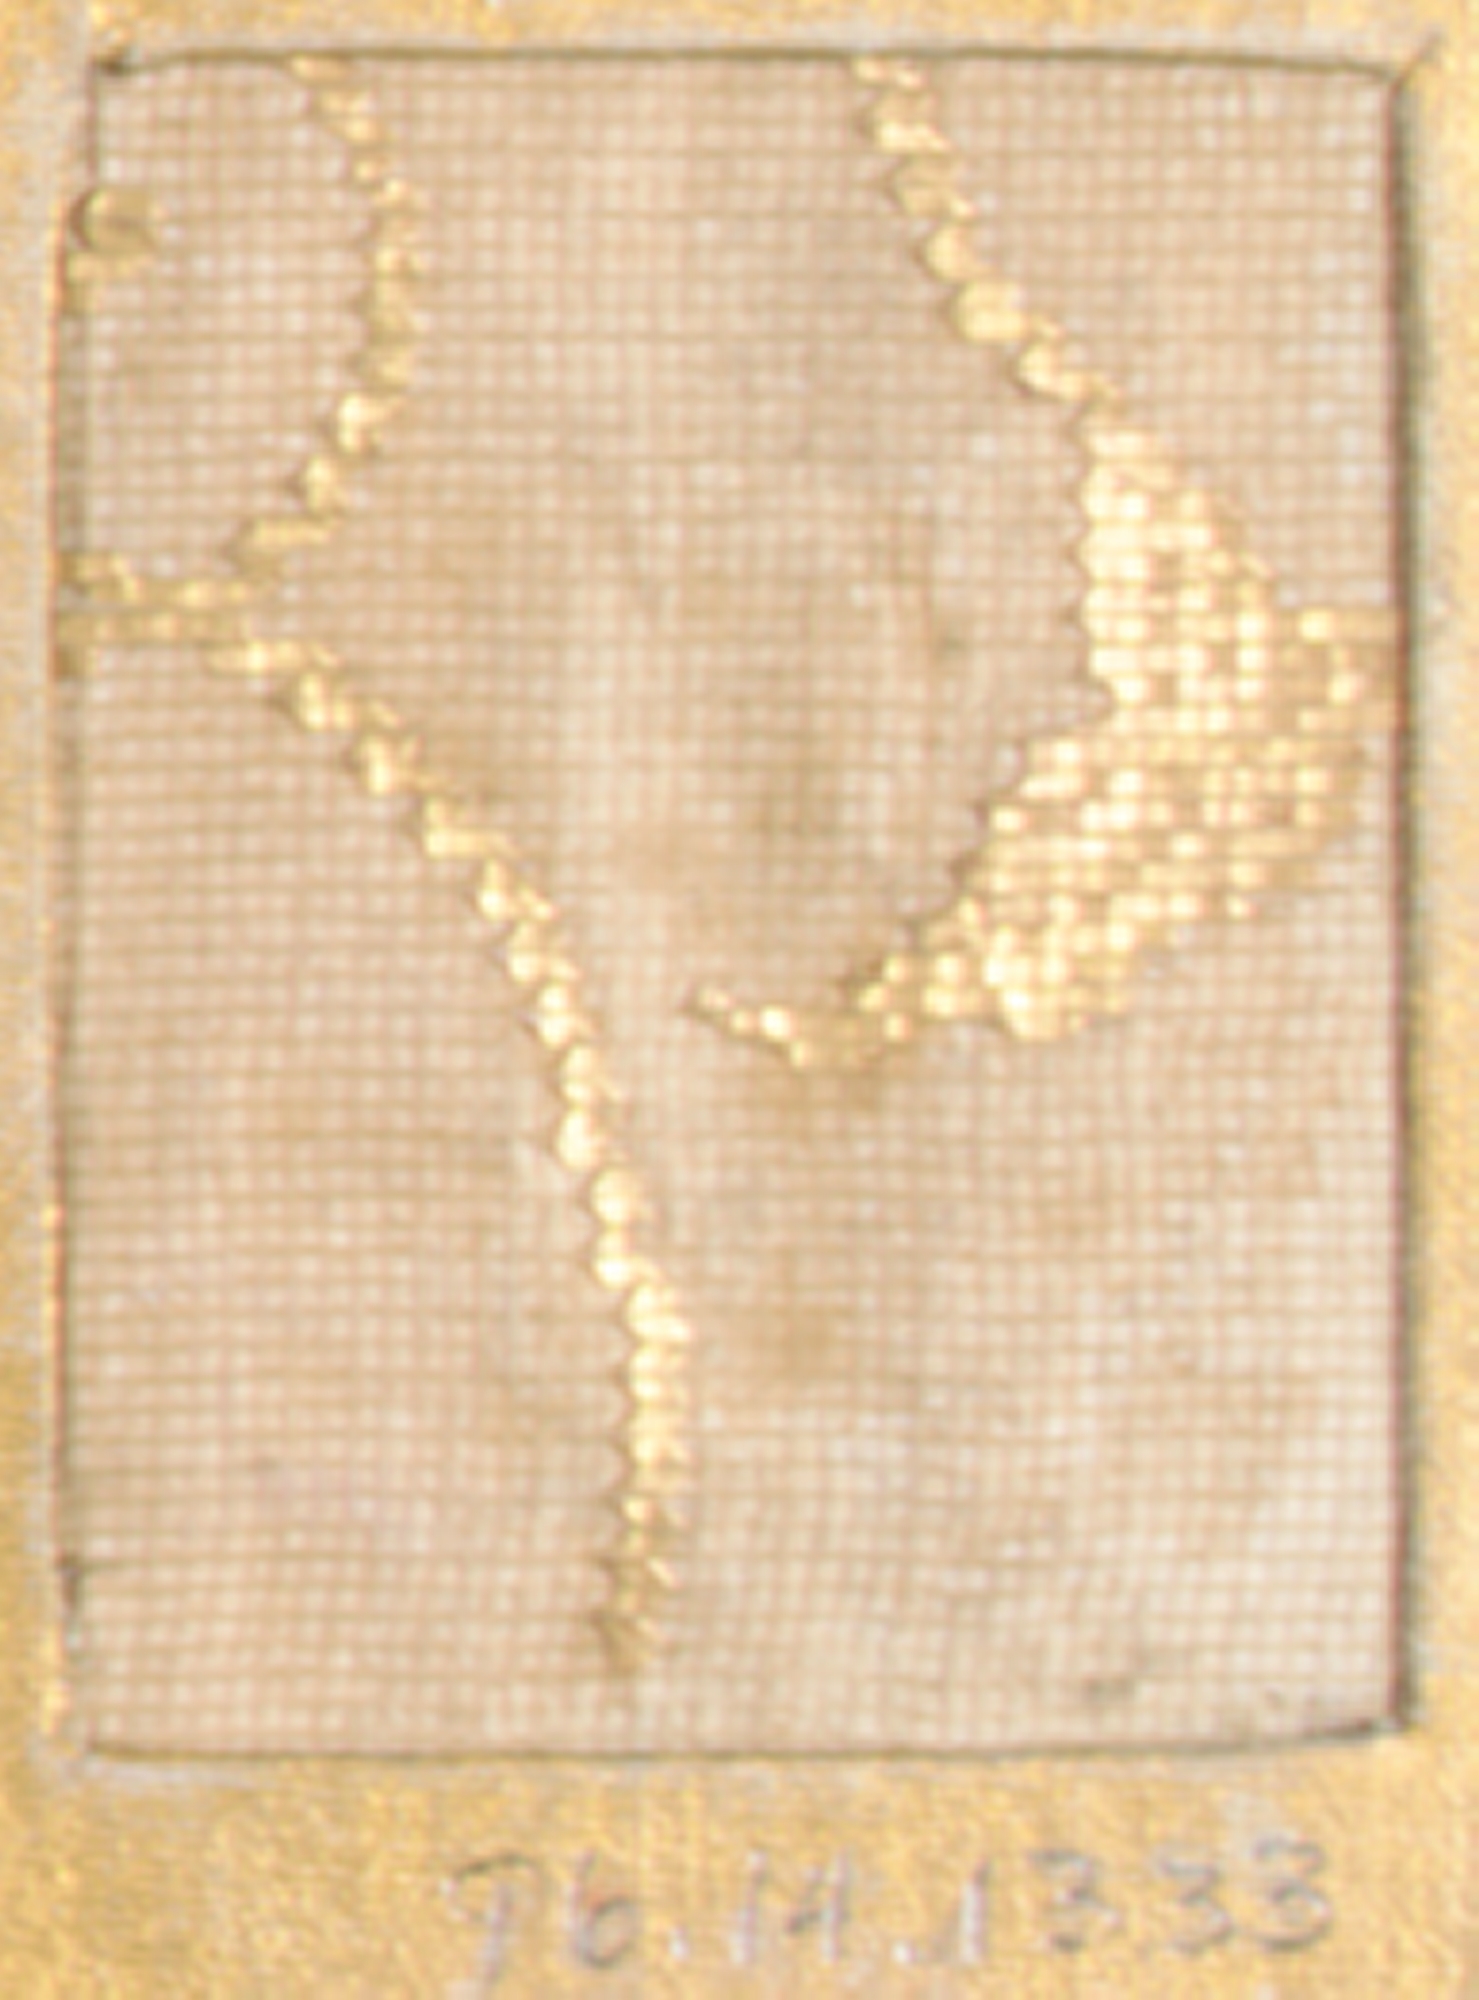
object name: piece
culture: japanese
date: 1701-1900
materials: silk